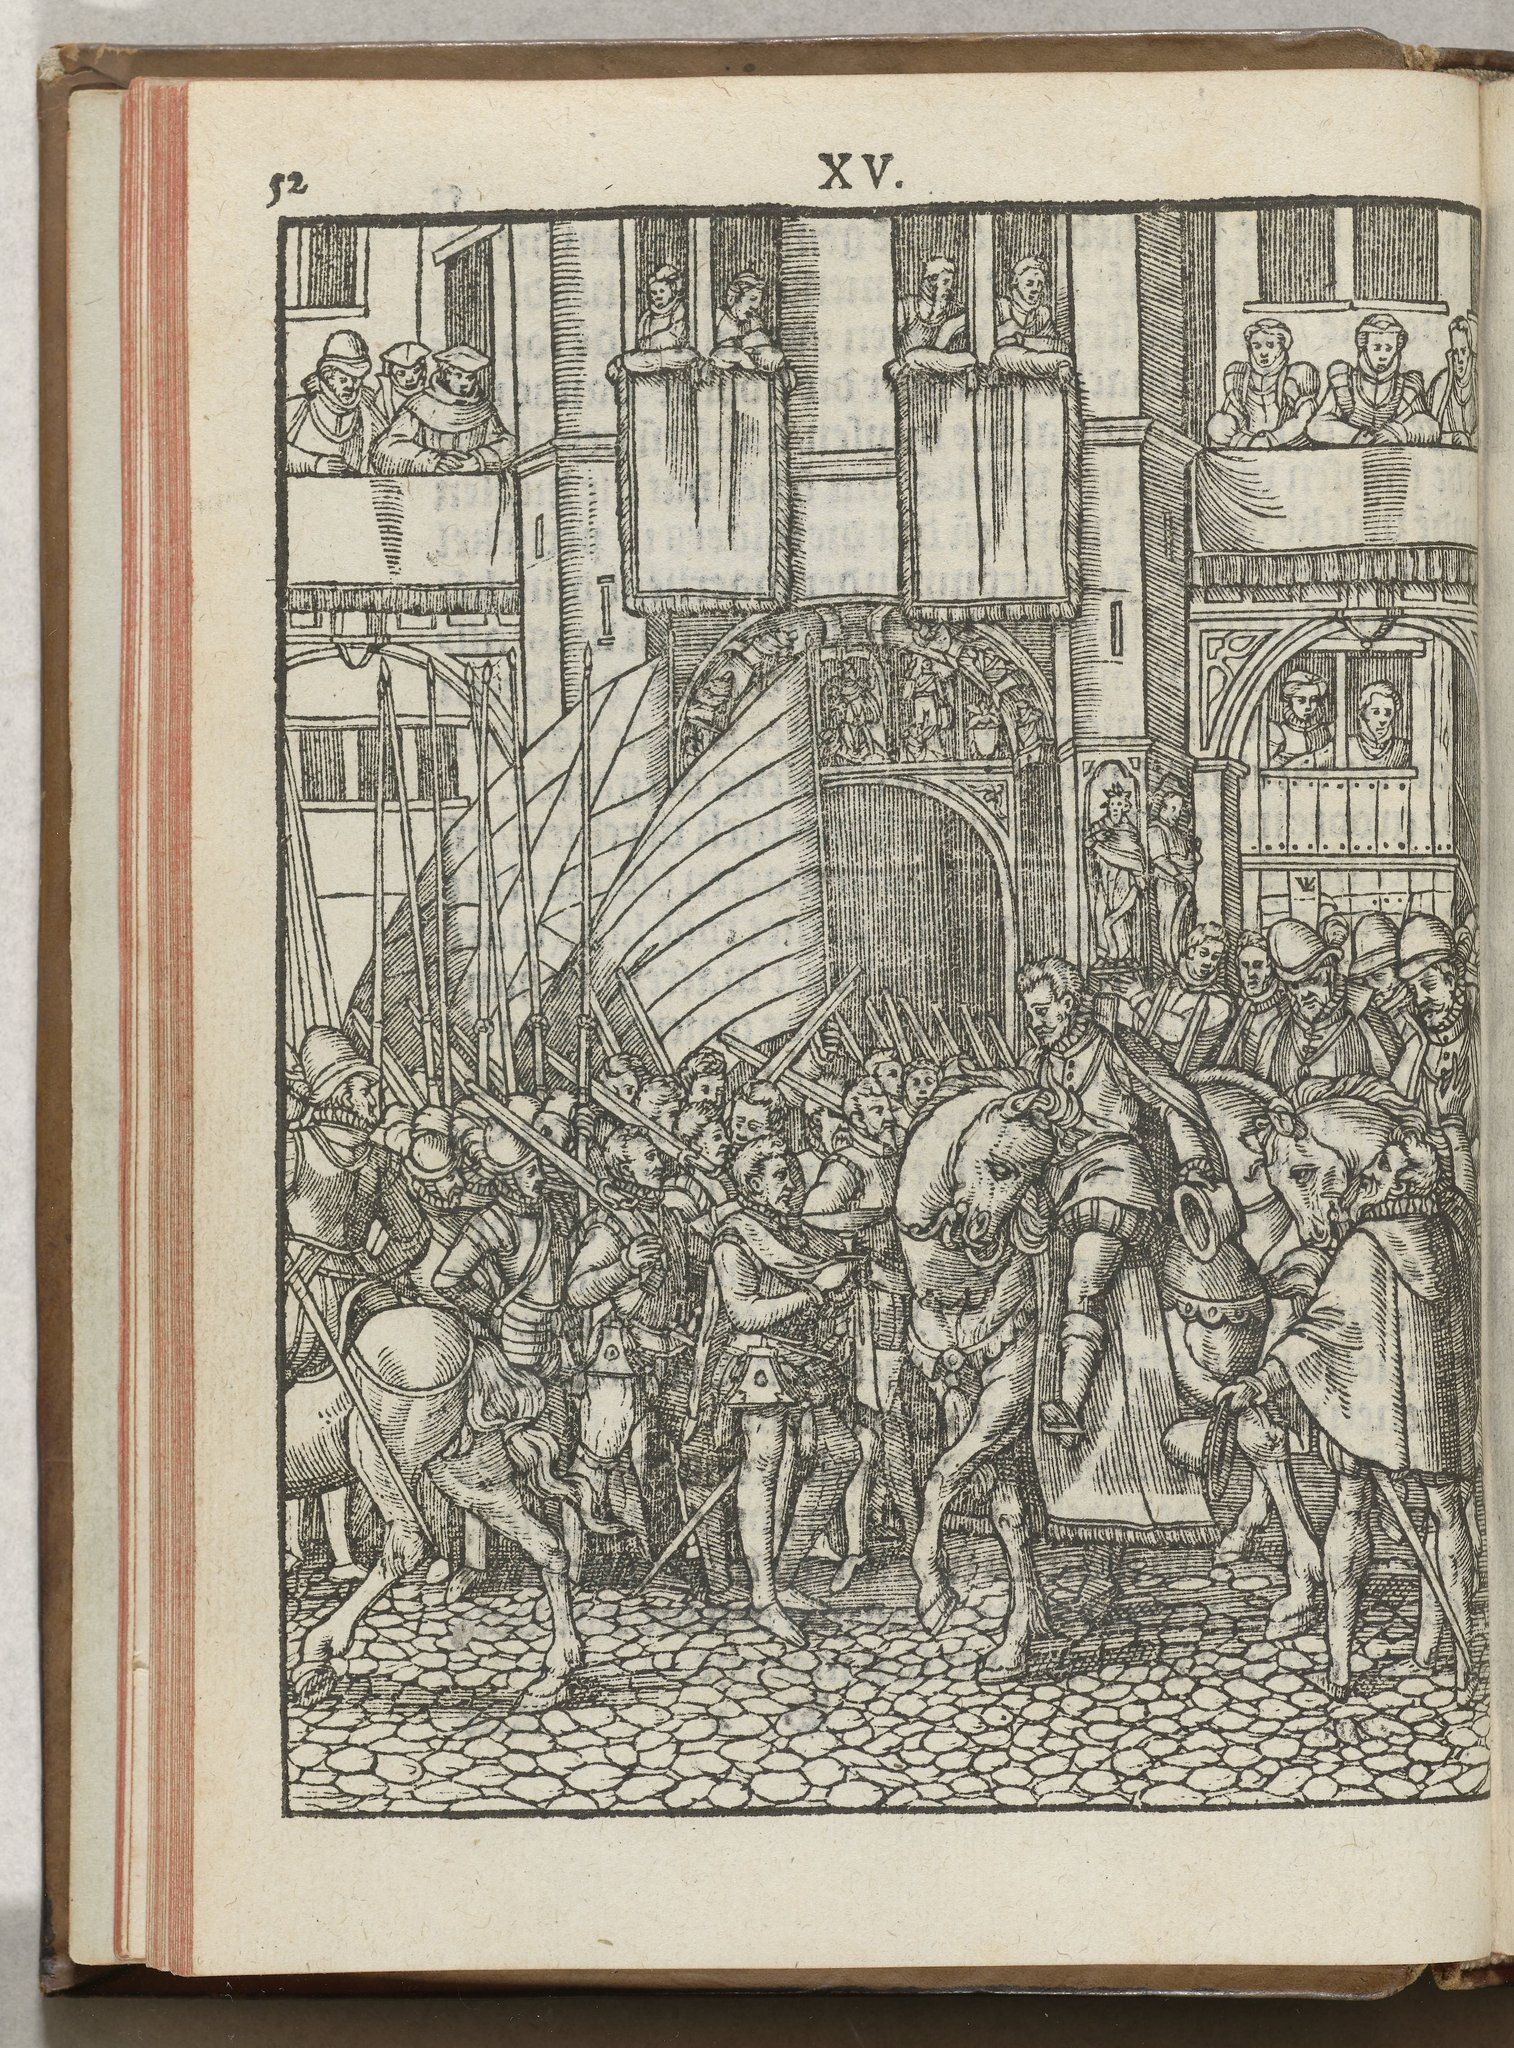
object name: print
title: Aanbieding van wijn en banket voor het stadhuis, 1577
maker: antoni van leest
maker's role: print maker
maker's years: 1545-1592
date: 1577-1578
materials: paper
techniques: woodcut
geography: netherlands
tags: delft, william i (prince of orange), triumphal entry and public reception, pageant, 'entrée solennelle', 'joyeuse entrée', brussels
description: Illustratie in: J. B. Houwaert, Declaratie van die triumphante incompst vande doorluchtighen ende hoogheboren Prine van Oraingnien, binnen die princelijcke stadt van Brussele, geschiet in t' iaer ... 1578, den 18 Septembris, Christoffel Plantijn, Antwerpen 1579. Boek in de bibliotheek met signatuur: 325 D 29.